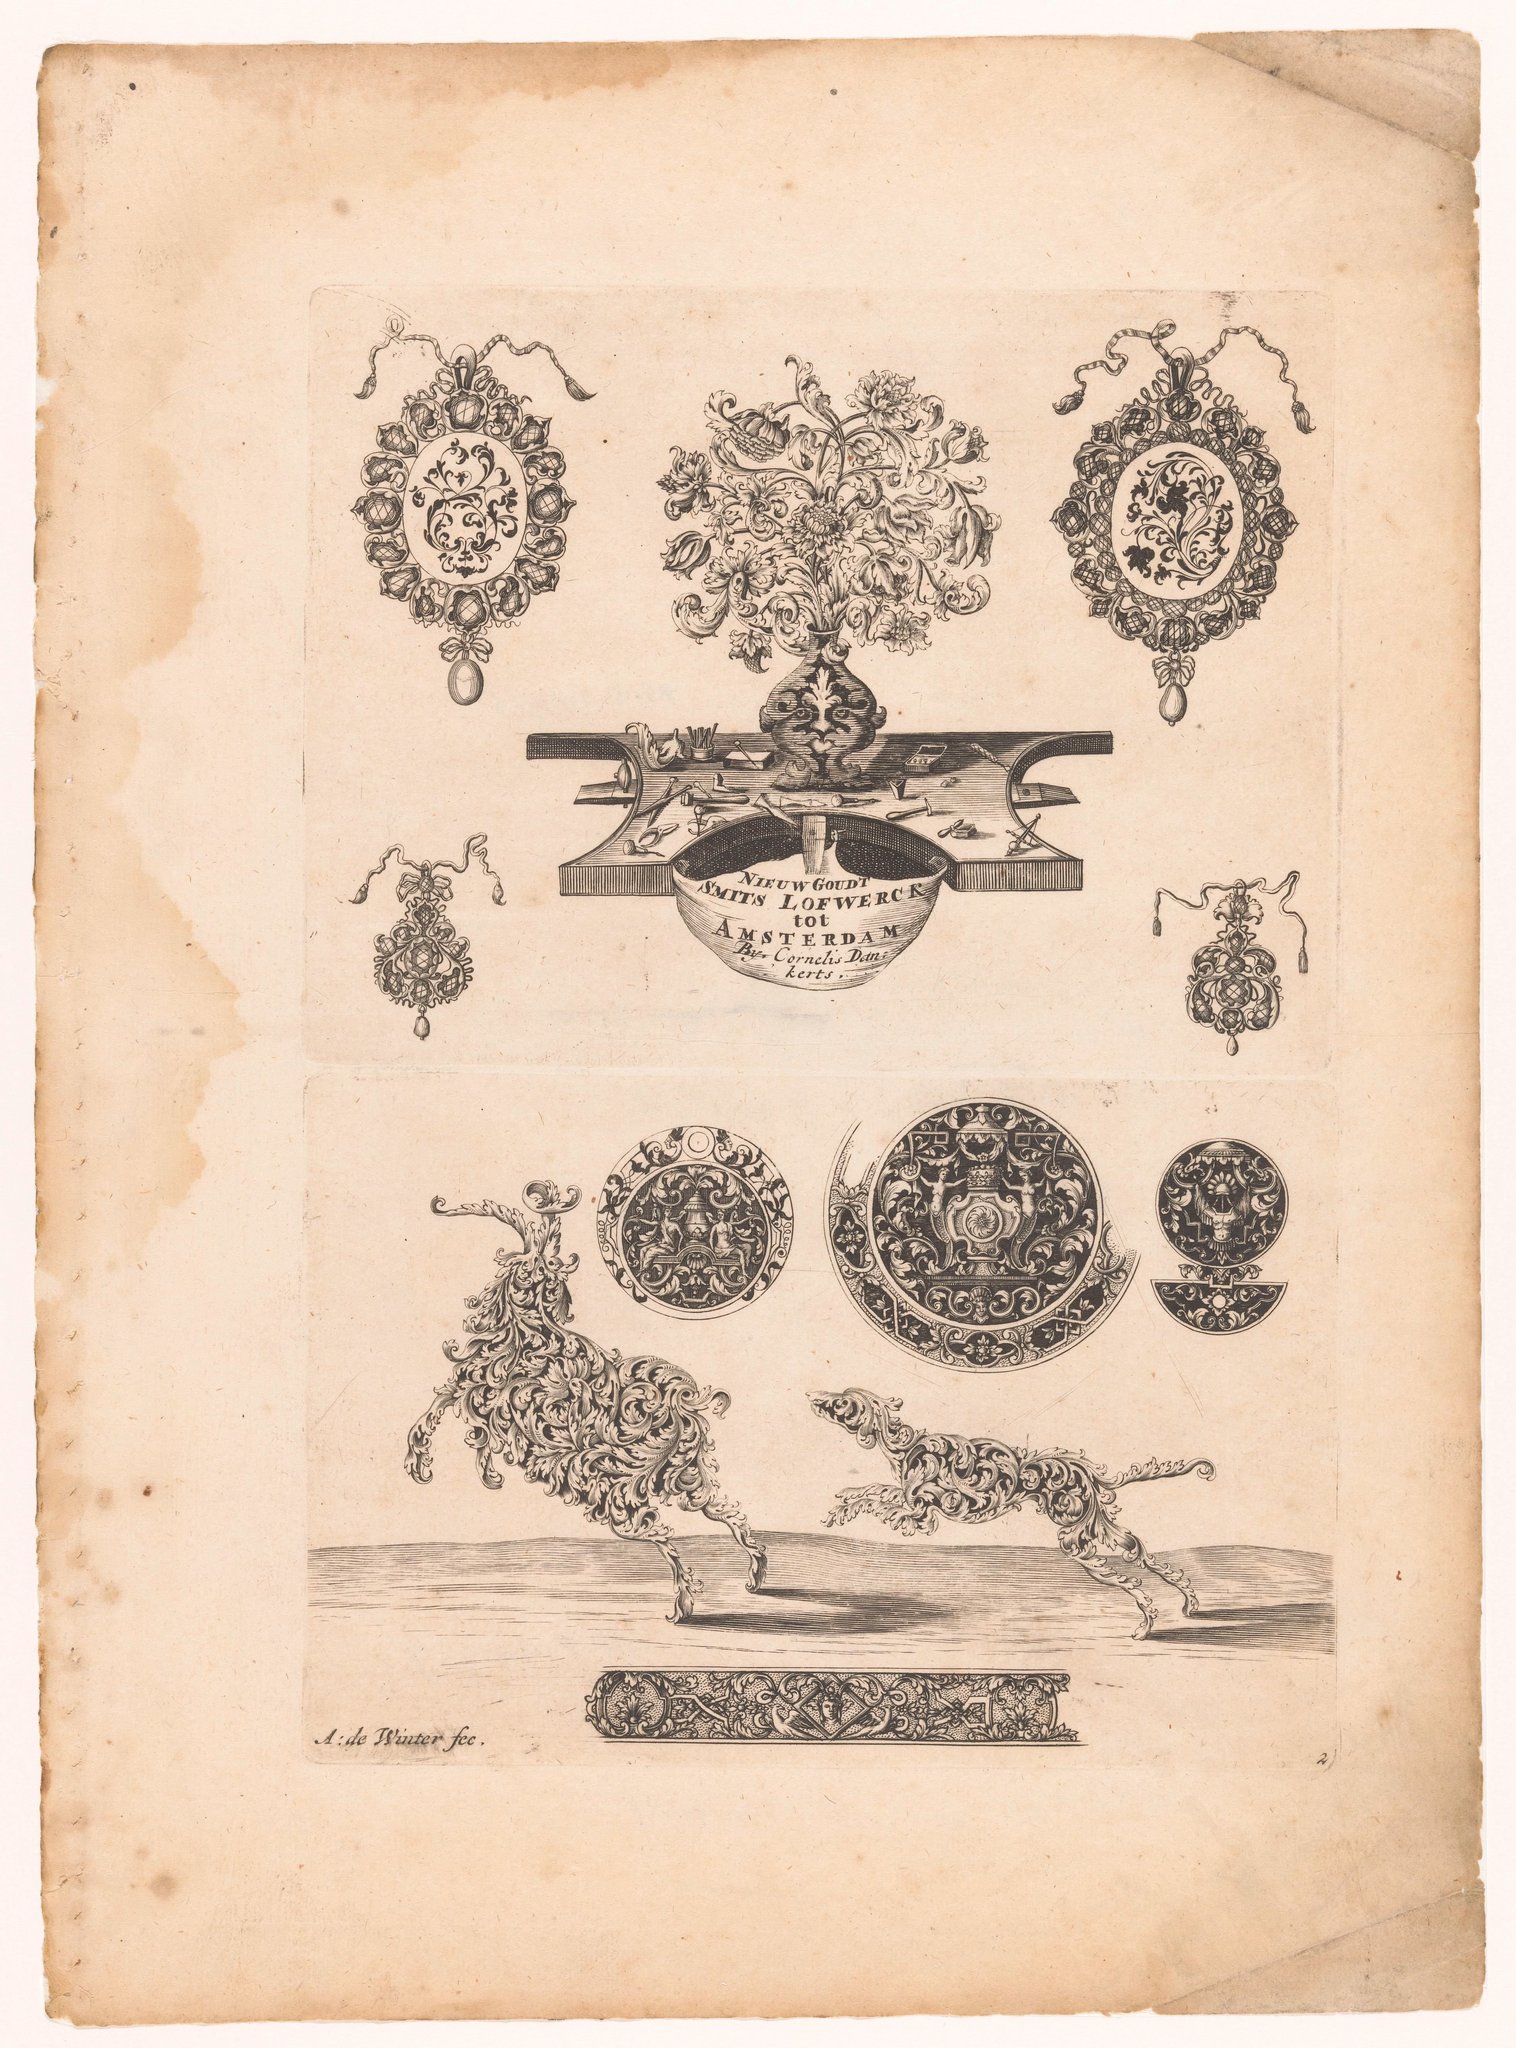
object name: ornament print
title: Nieuw Goudt Smits Lofwerck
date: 1698-1707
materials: paper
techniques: engraving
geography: netherlands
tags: ornaments ~ art, animal interlace ~ ornament, ram, vase ~ ornament, dog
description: Twee prenten op een blad. Modellen voor edelsmeden van dieren en figuren samengesteld uit bladornamenten, aangevuld met modellen voor juwelen. Boven: Vaas met bloemen op een tafel met goudsmidsgereedschap. Onder: Een ram achtervolgd door een hond.